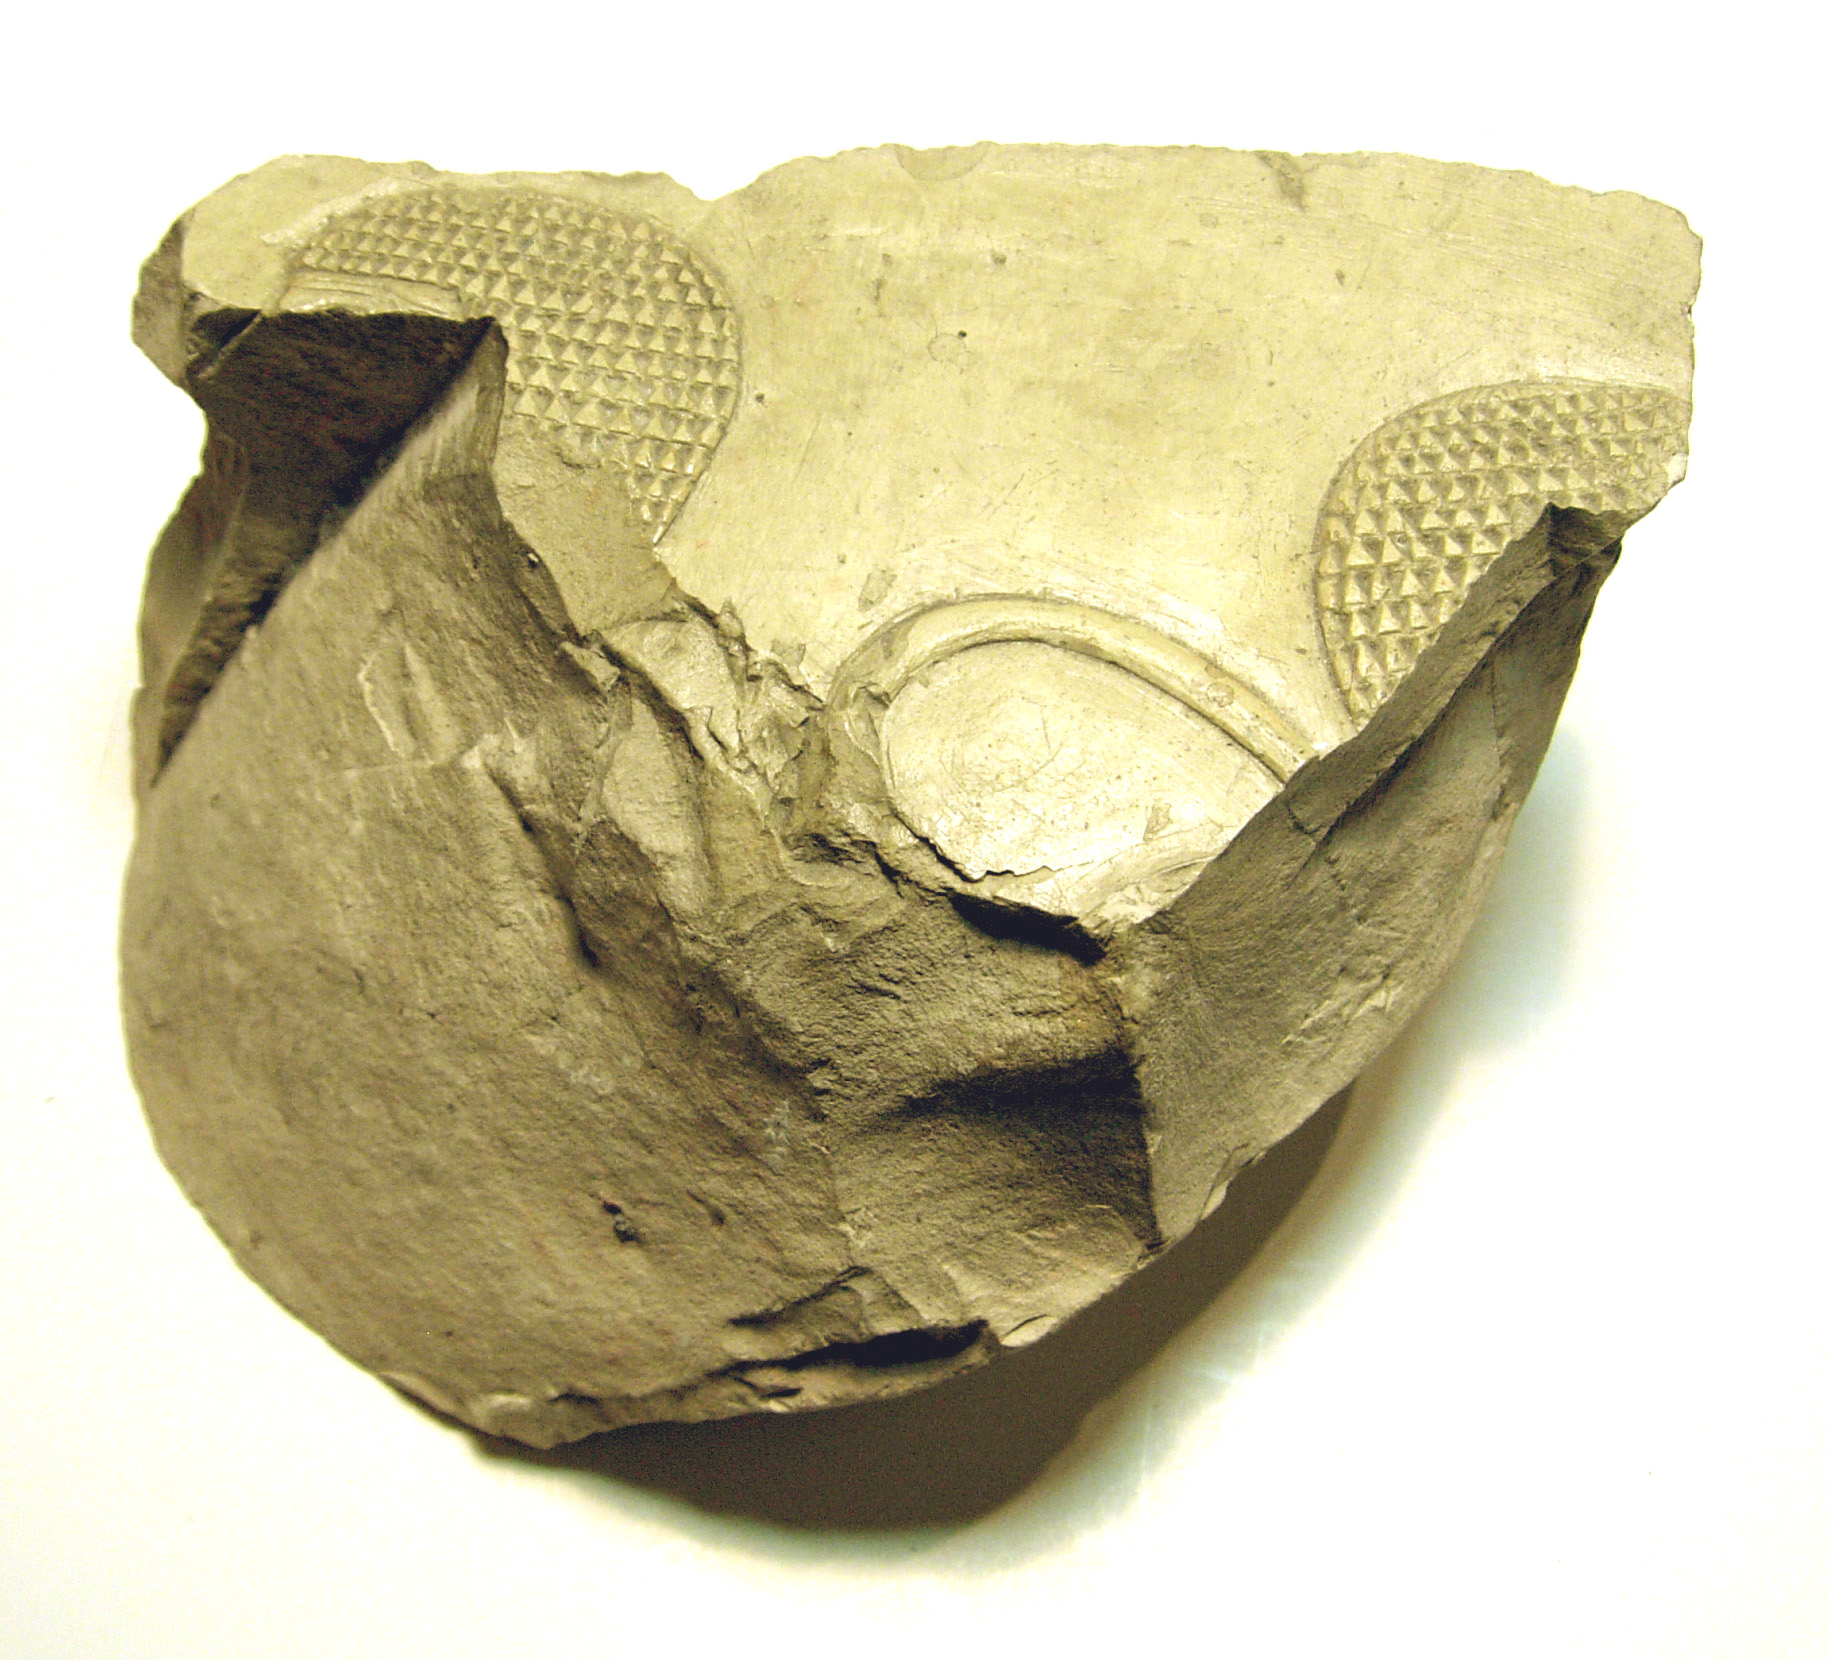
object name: relief, tomb of nespekashuty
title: Raised relief fragment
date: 664-610 BCE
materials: limestone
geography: egypt